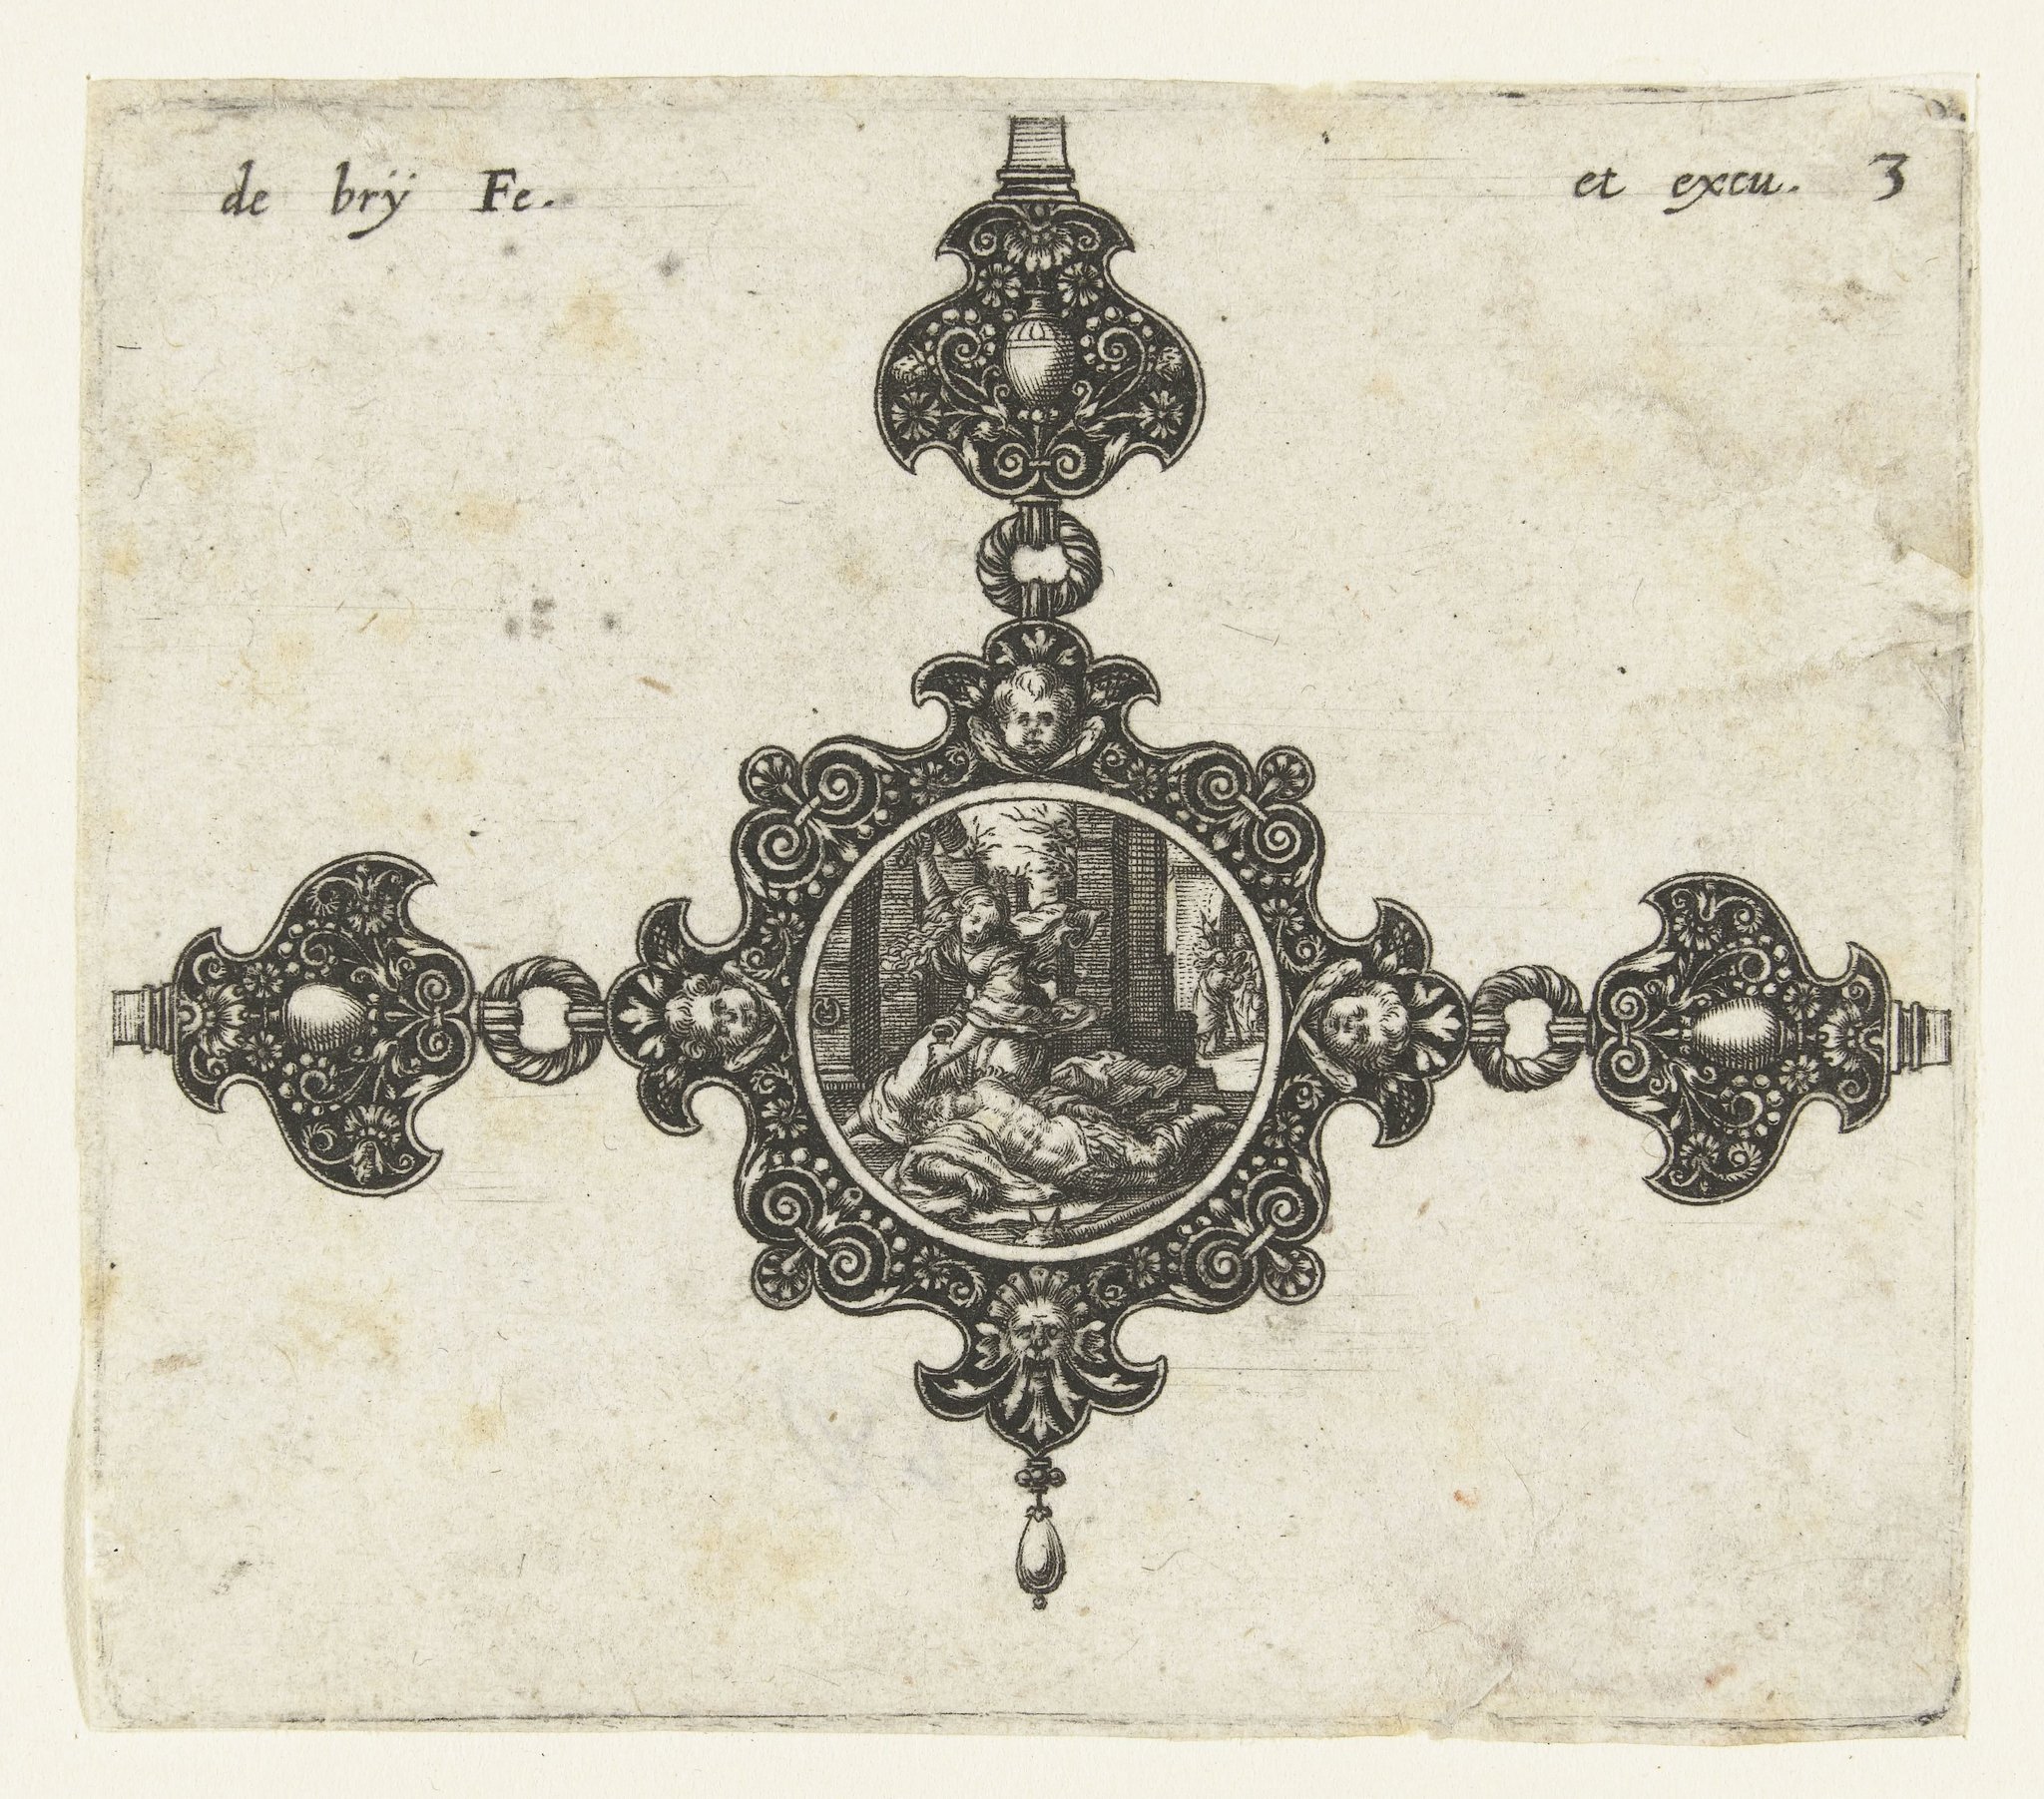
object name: ornament print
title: Verbindingsstuk, in het medaillon Jaël die Sisera doodt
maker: johann theodor de bry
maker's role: print maker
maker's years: 1561-1623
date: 1571-1623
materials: paper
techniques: engraving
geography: germany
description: De omlijsting wordt gevormd door arabesken, drie cherubijntjes en een saterkop. Onderaan hangt een peervormige parel. Blad 3 van een serie van 4 bladen met ovalen of medaillons in een omlijsting van grotesken en arabesken op zwart fond. Aan de bovenzijde en aan de zijkanten zijn aansluitpunten voor kettingen.